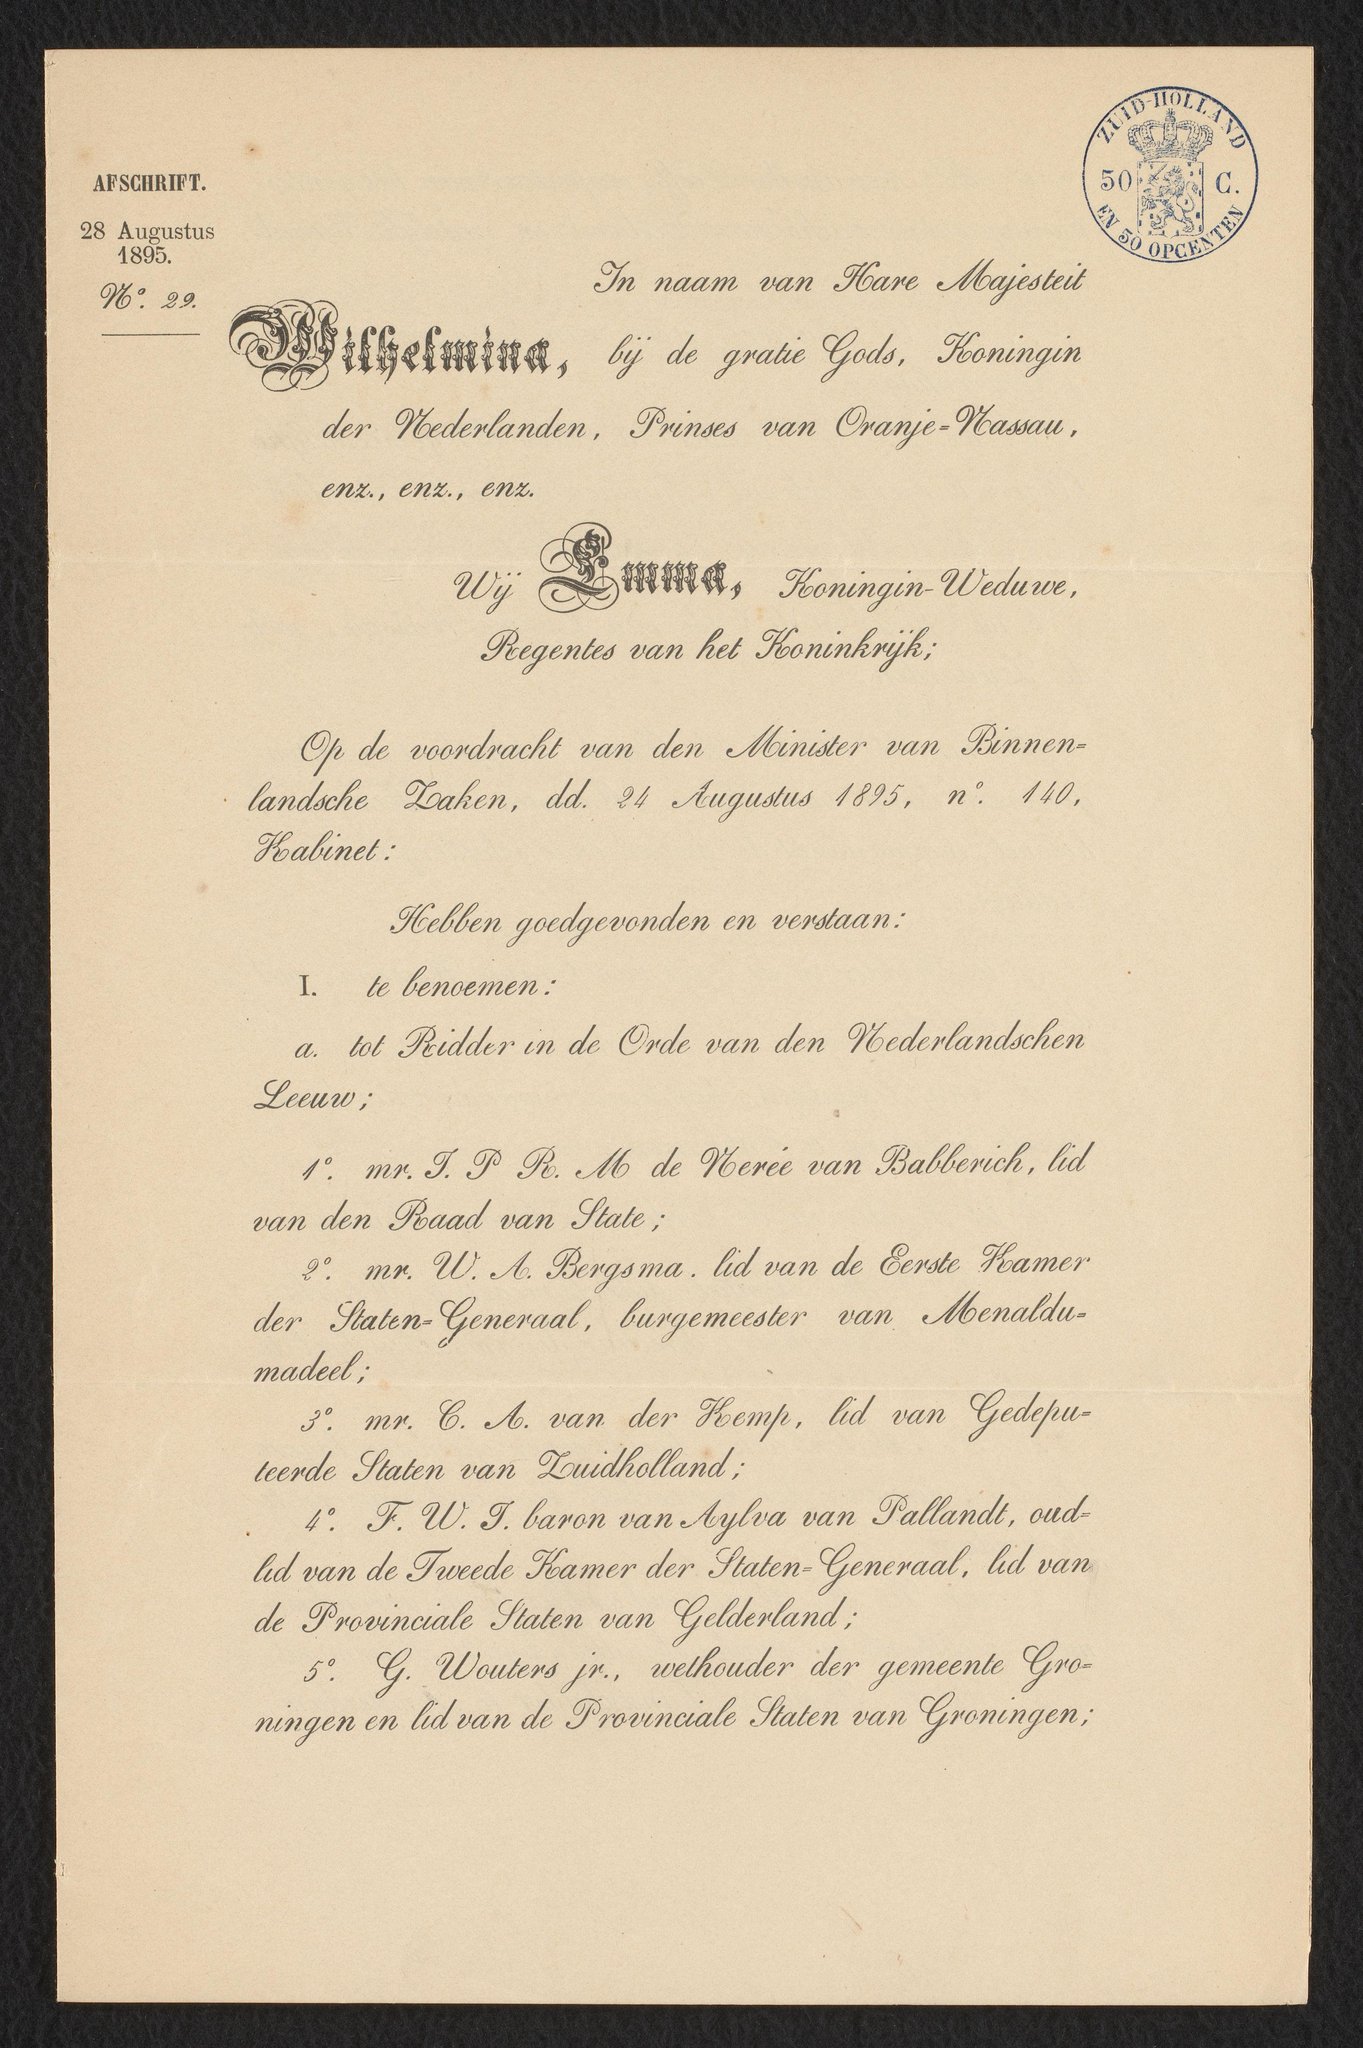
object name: document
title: Afschrift gericht aan George Hendrik Breitner, afkomstig van het Koninklijk Huis, betreffende een benoeming in de Orde van Oranje-Nassau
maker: Anonymous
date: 1895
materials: ink, paper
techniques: printing, letterpress printing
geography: the hague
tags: wilhelmina of the netherlands, rotterdam, amsterdam, painter, print maker, draughtsman, george hendrik breitner, emma (queen consort of the netherlands), distribution of awards ~ art contest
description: Afschrift gericht aan George Hendrik Breitner, ondertekend namens koningin-regentes Emma en koningin Wilhelmina, met de officiële goedkeuring dat George Hendrik Breitner wordt benoemd in de Orde van Oranje-Nassau.